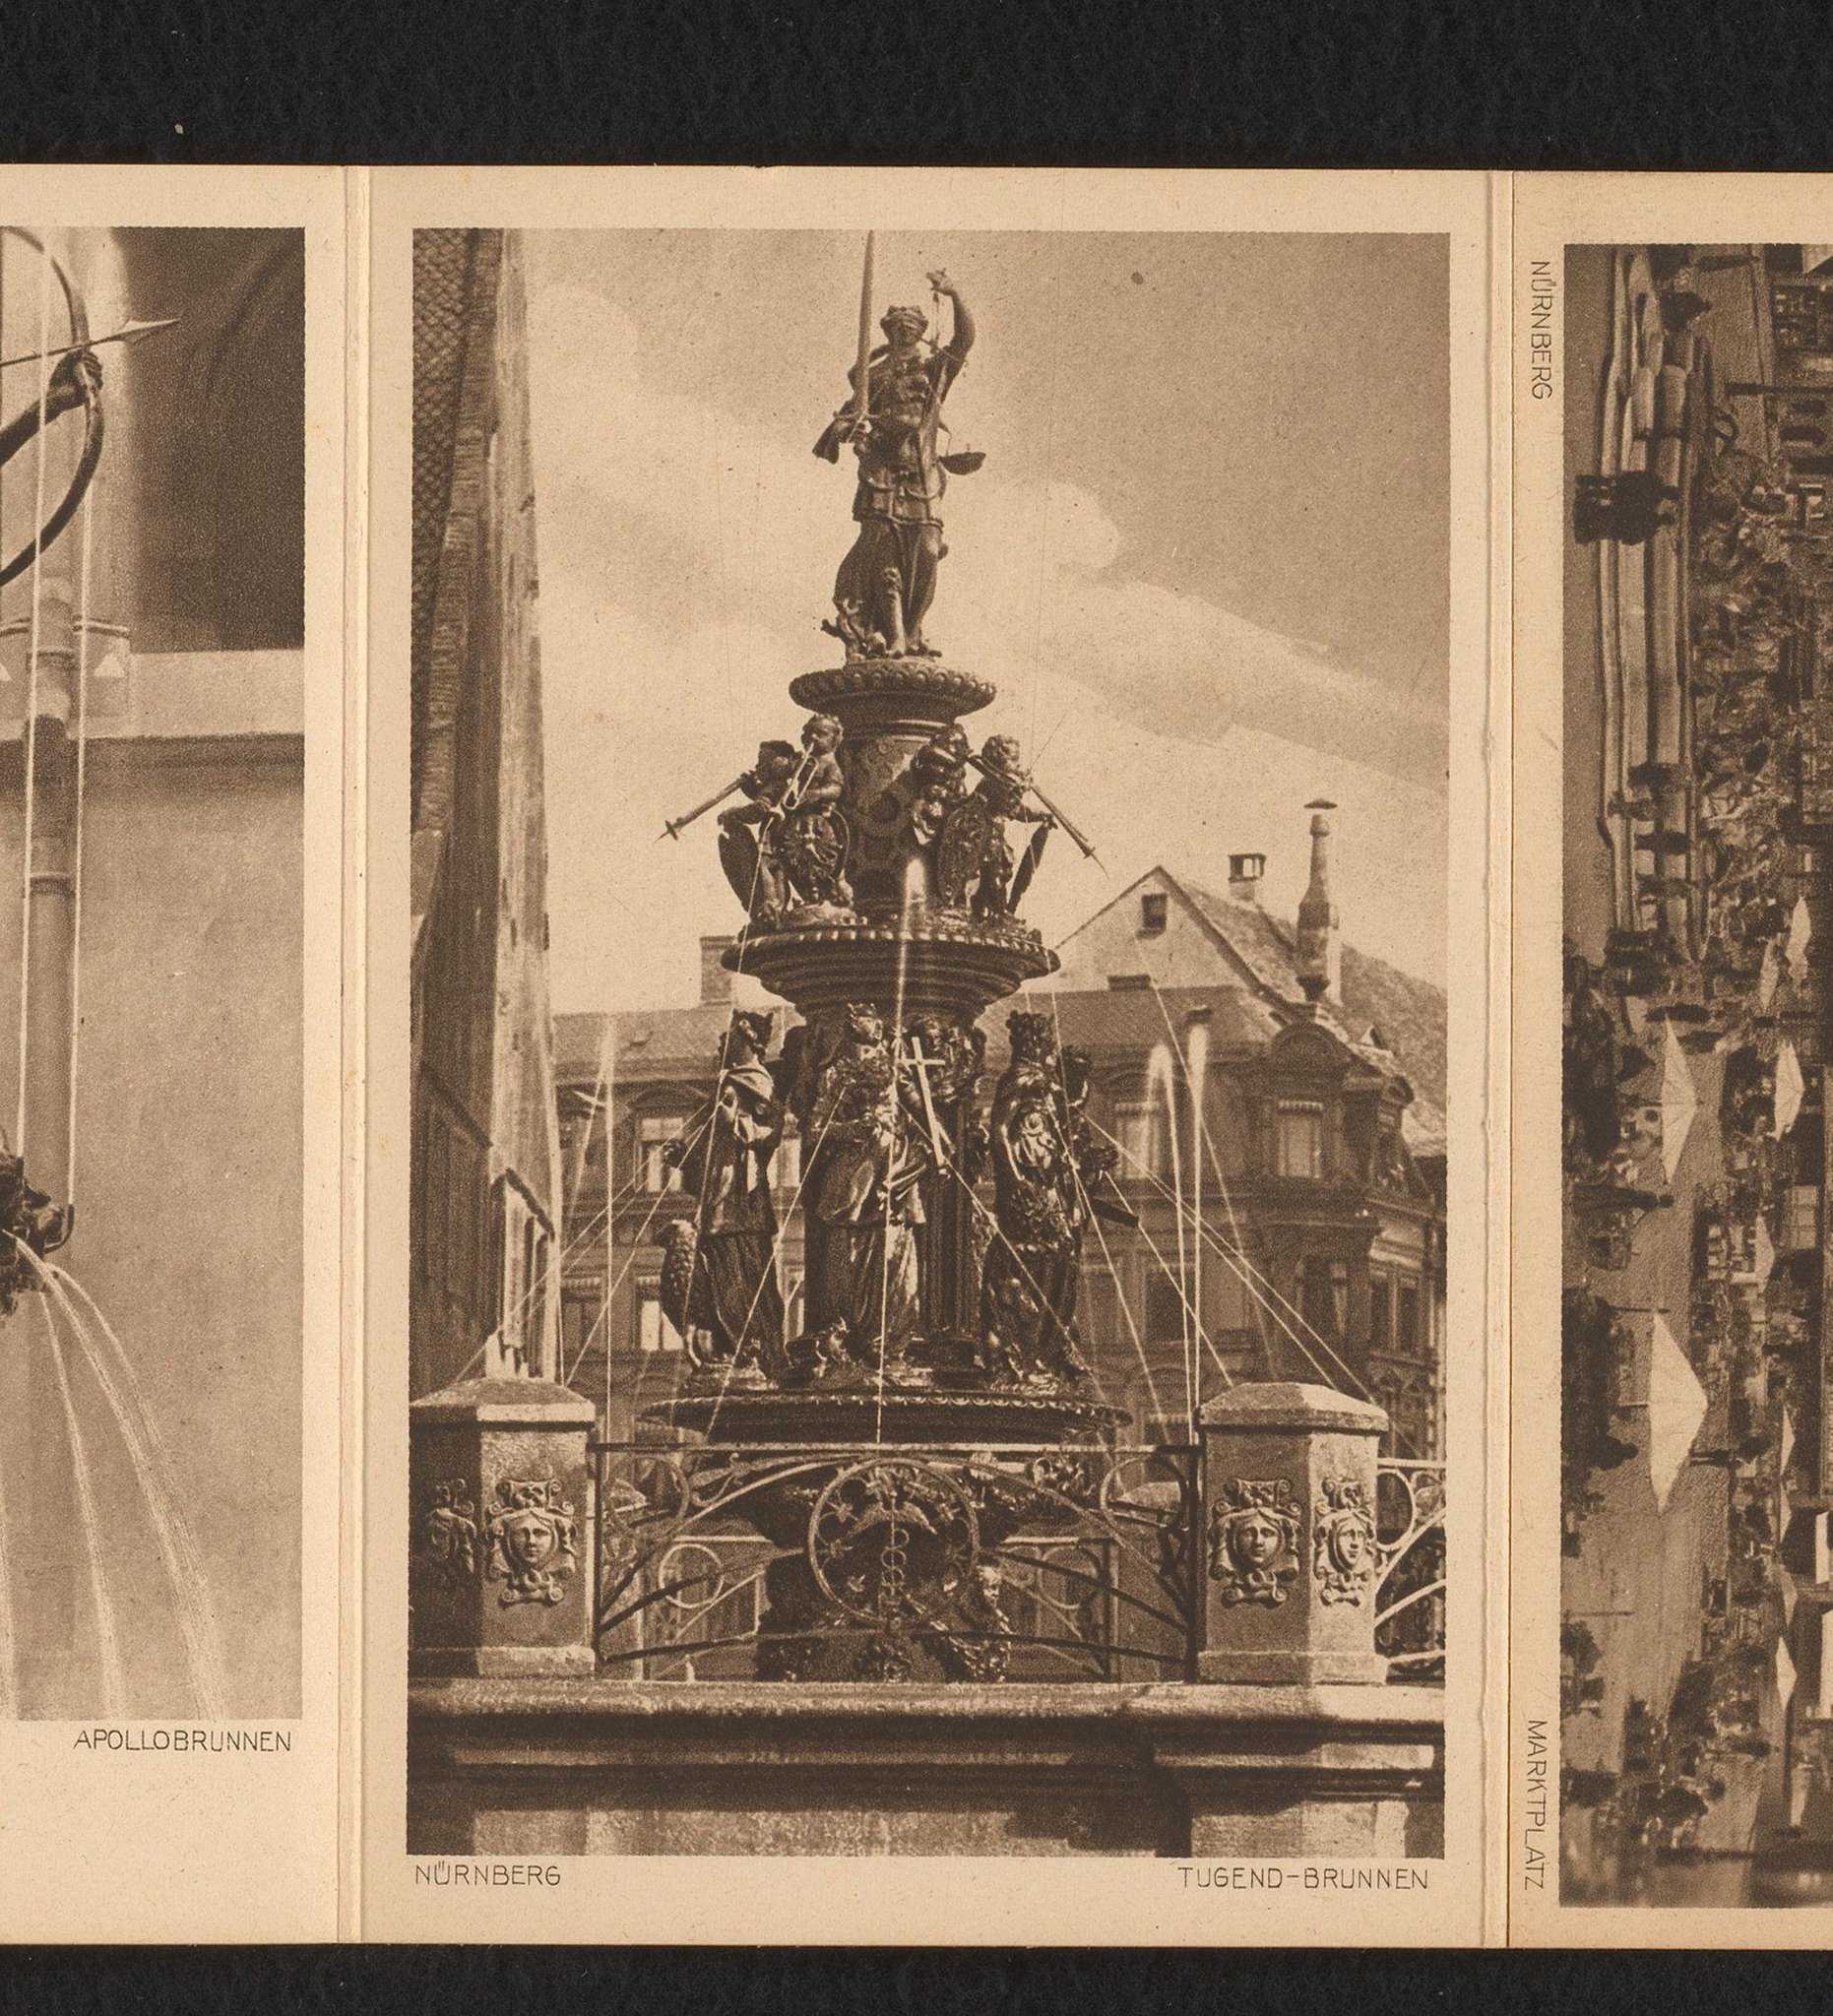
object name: photomechanical print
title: Nürnberg. Marktplatz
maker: Anonymous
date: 1905-1930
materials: cardboard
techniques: rotogravure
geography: nuremberg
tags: square, place, circus, etc., market